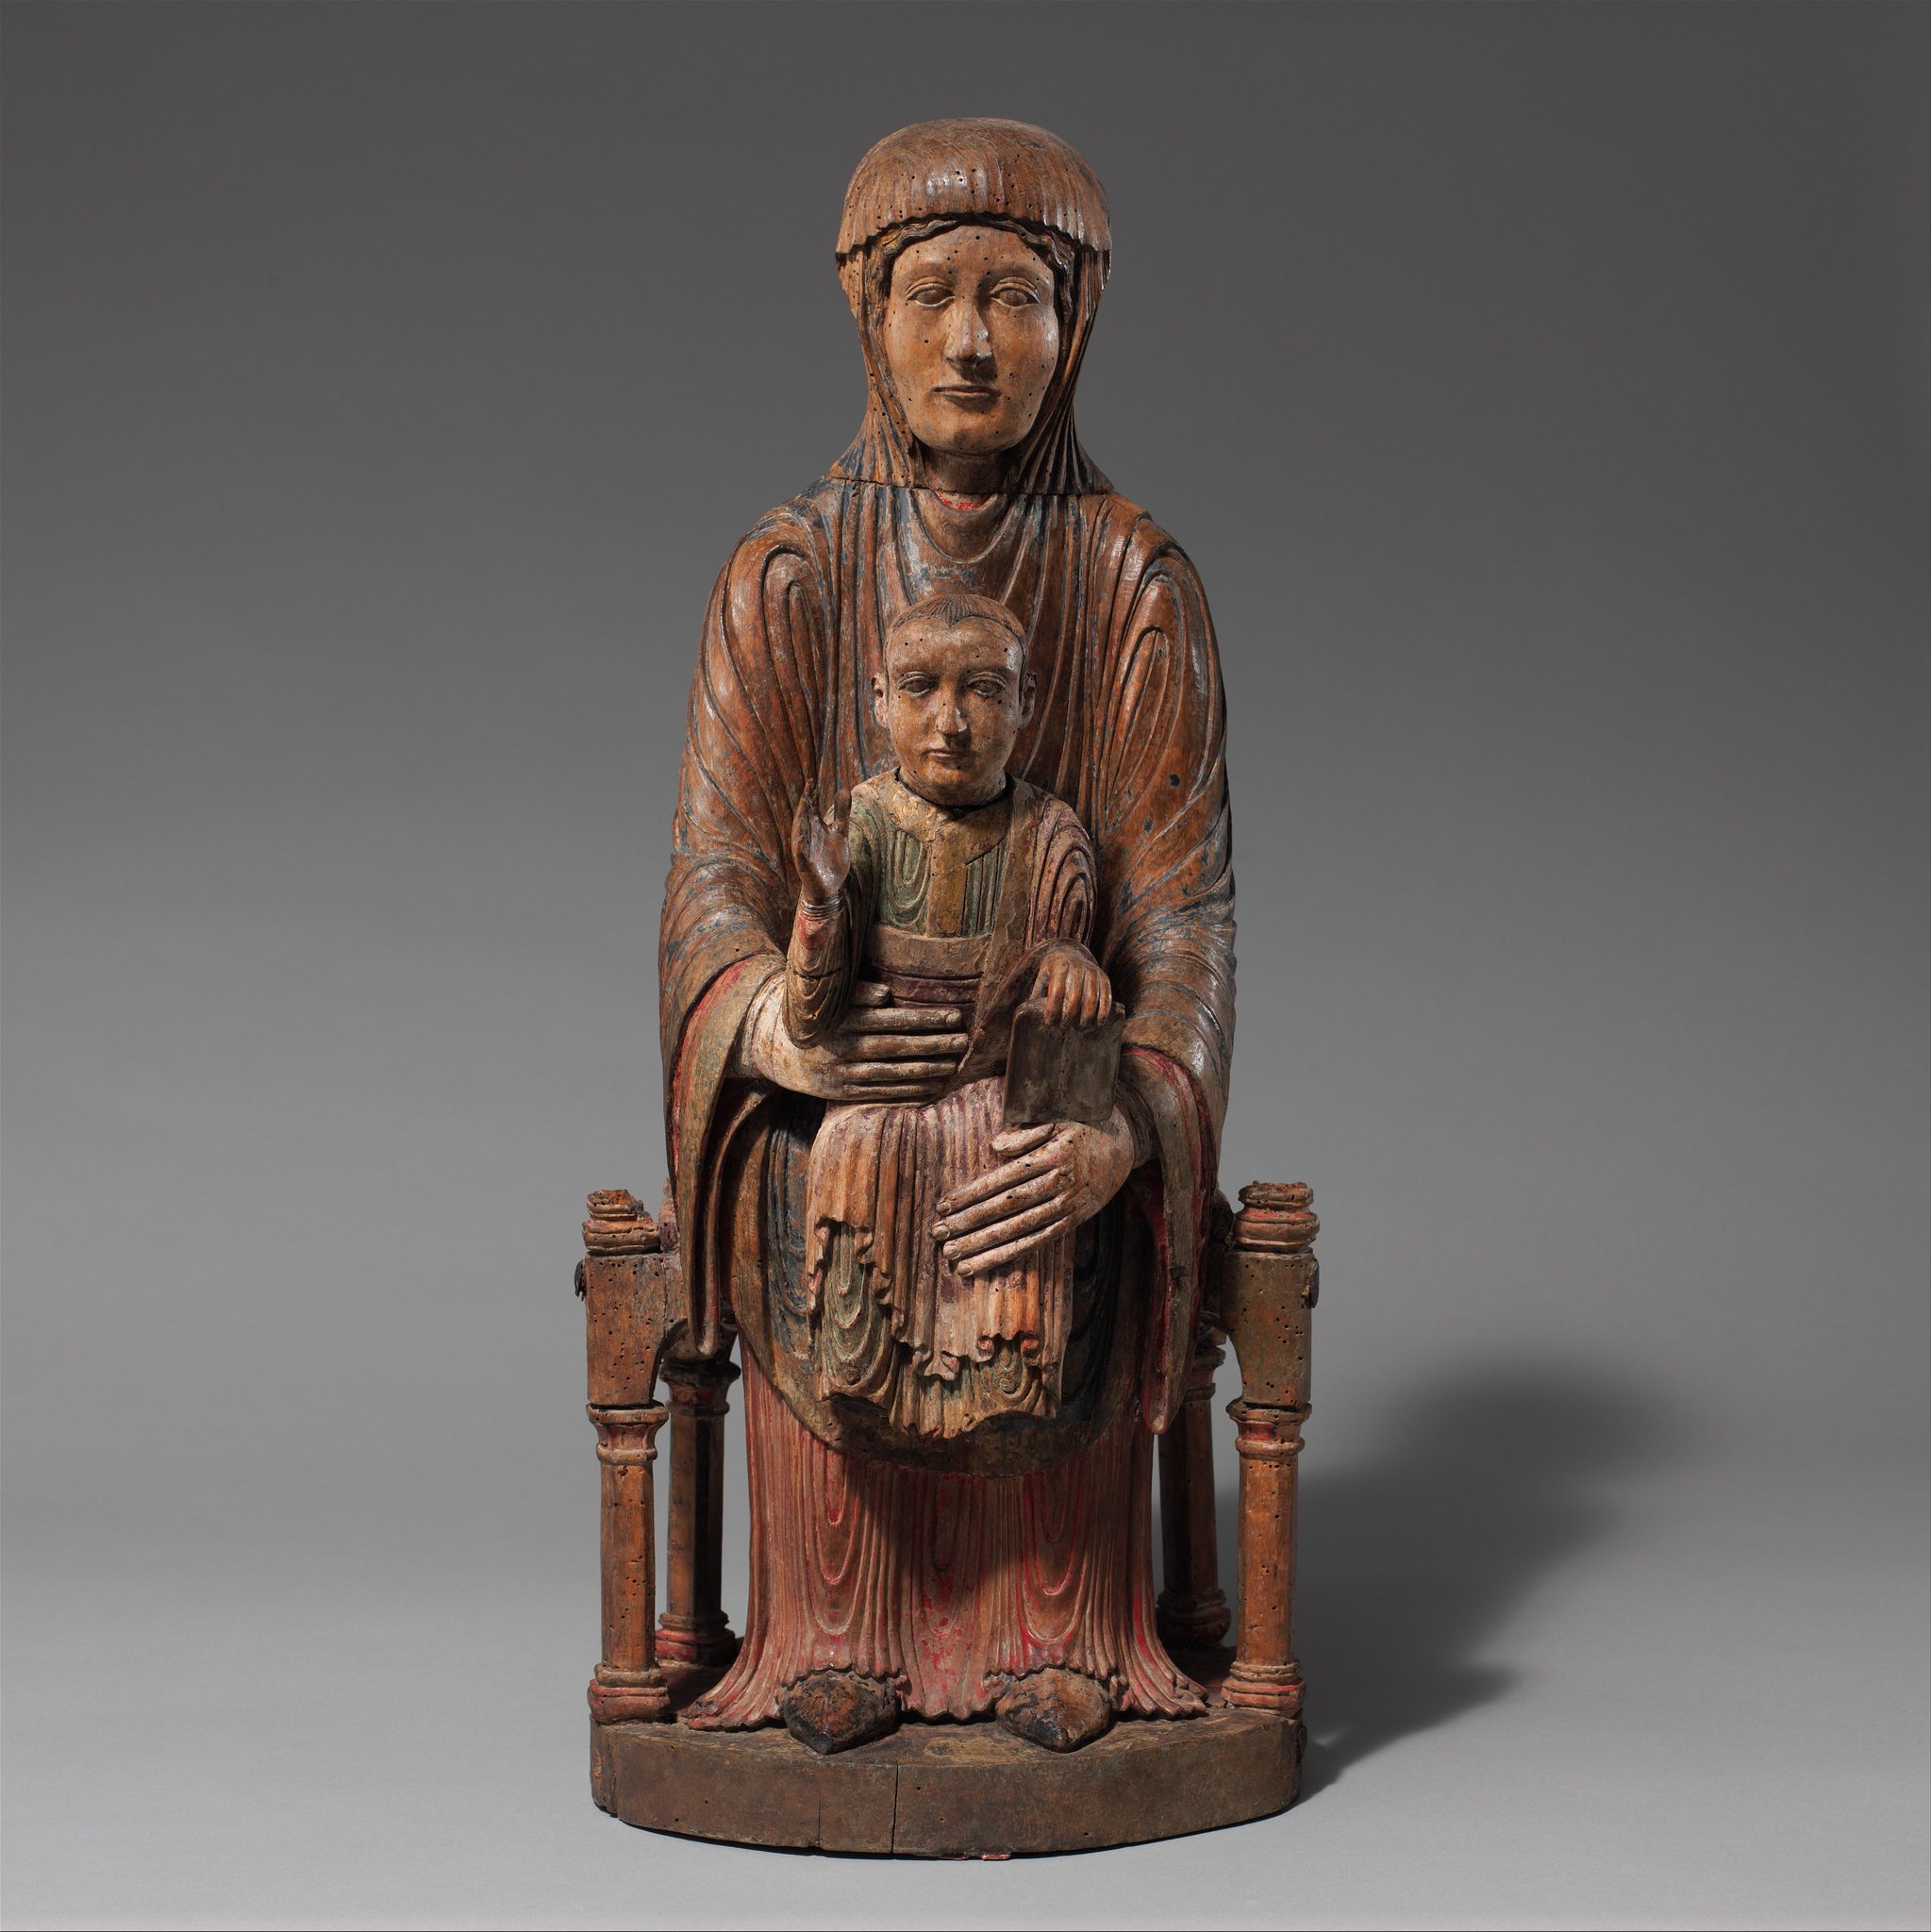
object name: sculpture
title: Enthroned Virgin and Child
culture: french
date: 1150-1200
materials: gesso, linen, paint, tin, wood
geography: france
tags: madonna and child